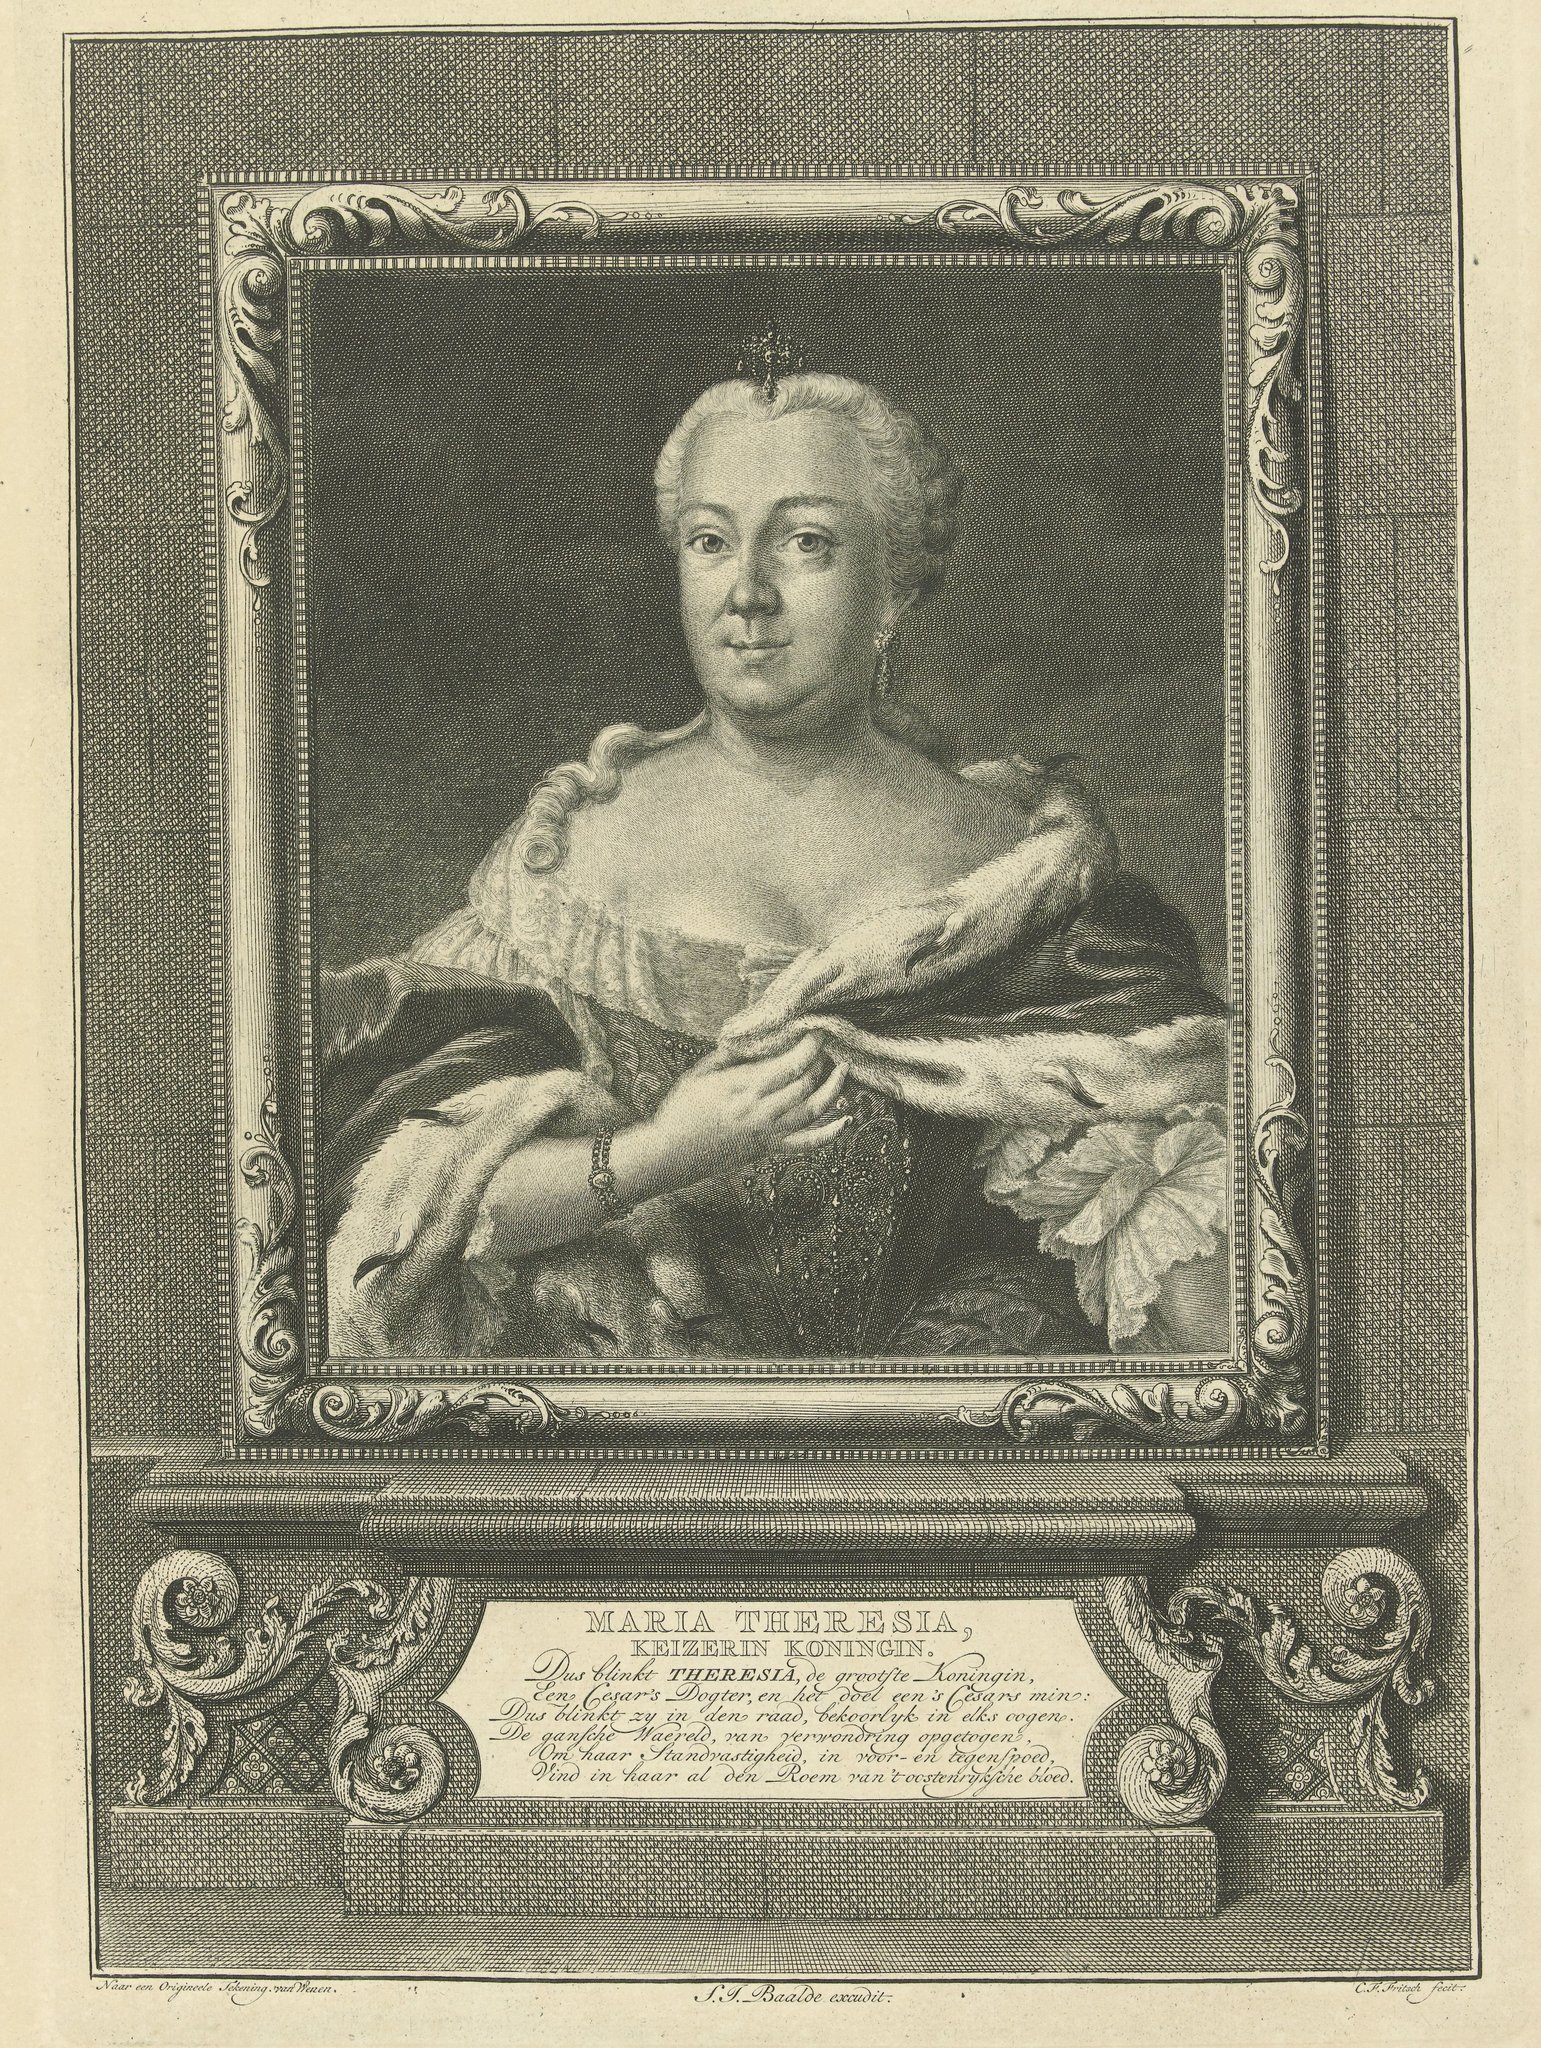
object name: print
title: Portret van Maria Theresia, Rooms-Duits keizerin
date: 1755-1788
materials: paper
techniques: engraving, etching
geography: amsterdam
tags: vienna, maria theresia (rooms-duits keizerin)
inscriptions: collector's mark: Lugt 2228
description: Portretbuste van de Rooms-Duitse keizerin Maria Theresia in kroningsmantel, een sieraad in het haar. Het portret is omkaderd met een sierlijke lijst en staat op een sokkel waarop haar naam, titel en een zesregelige tekst in het Nederlands staan.